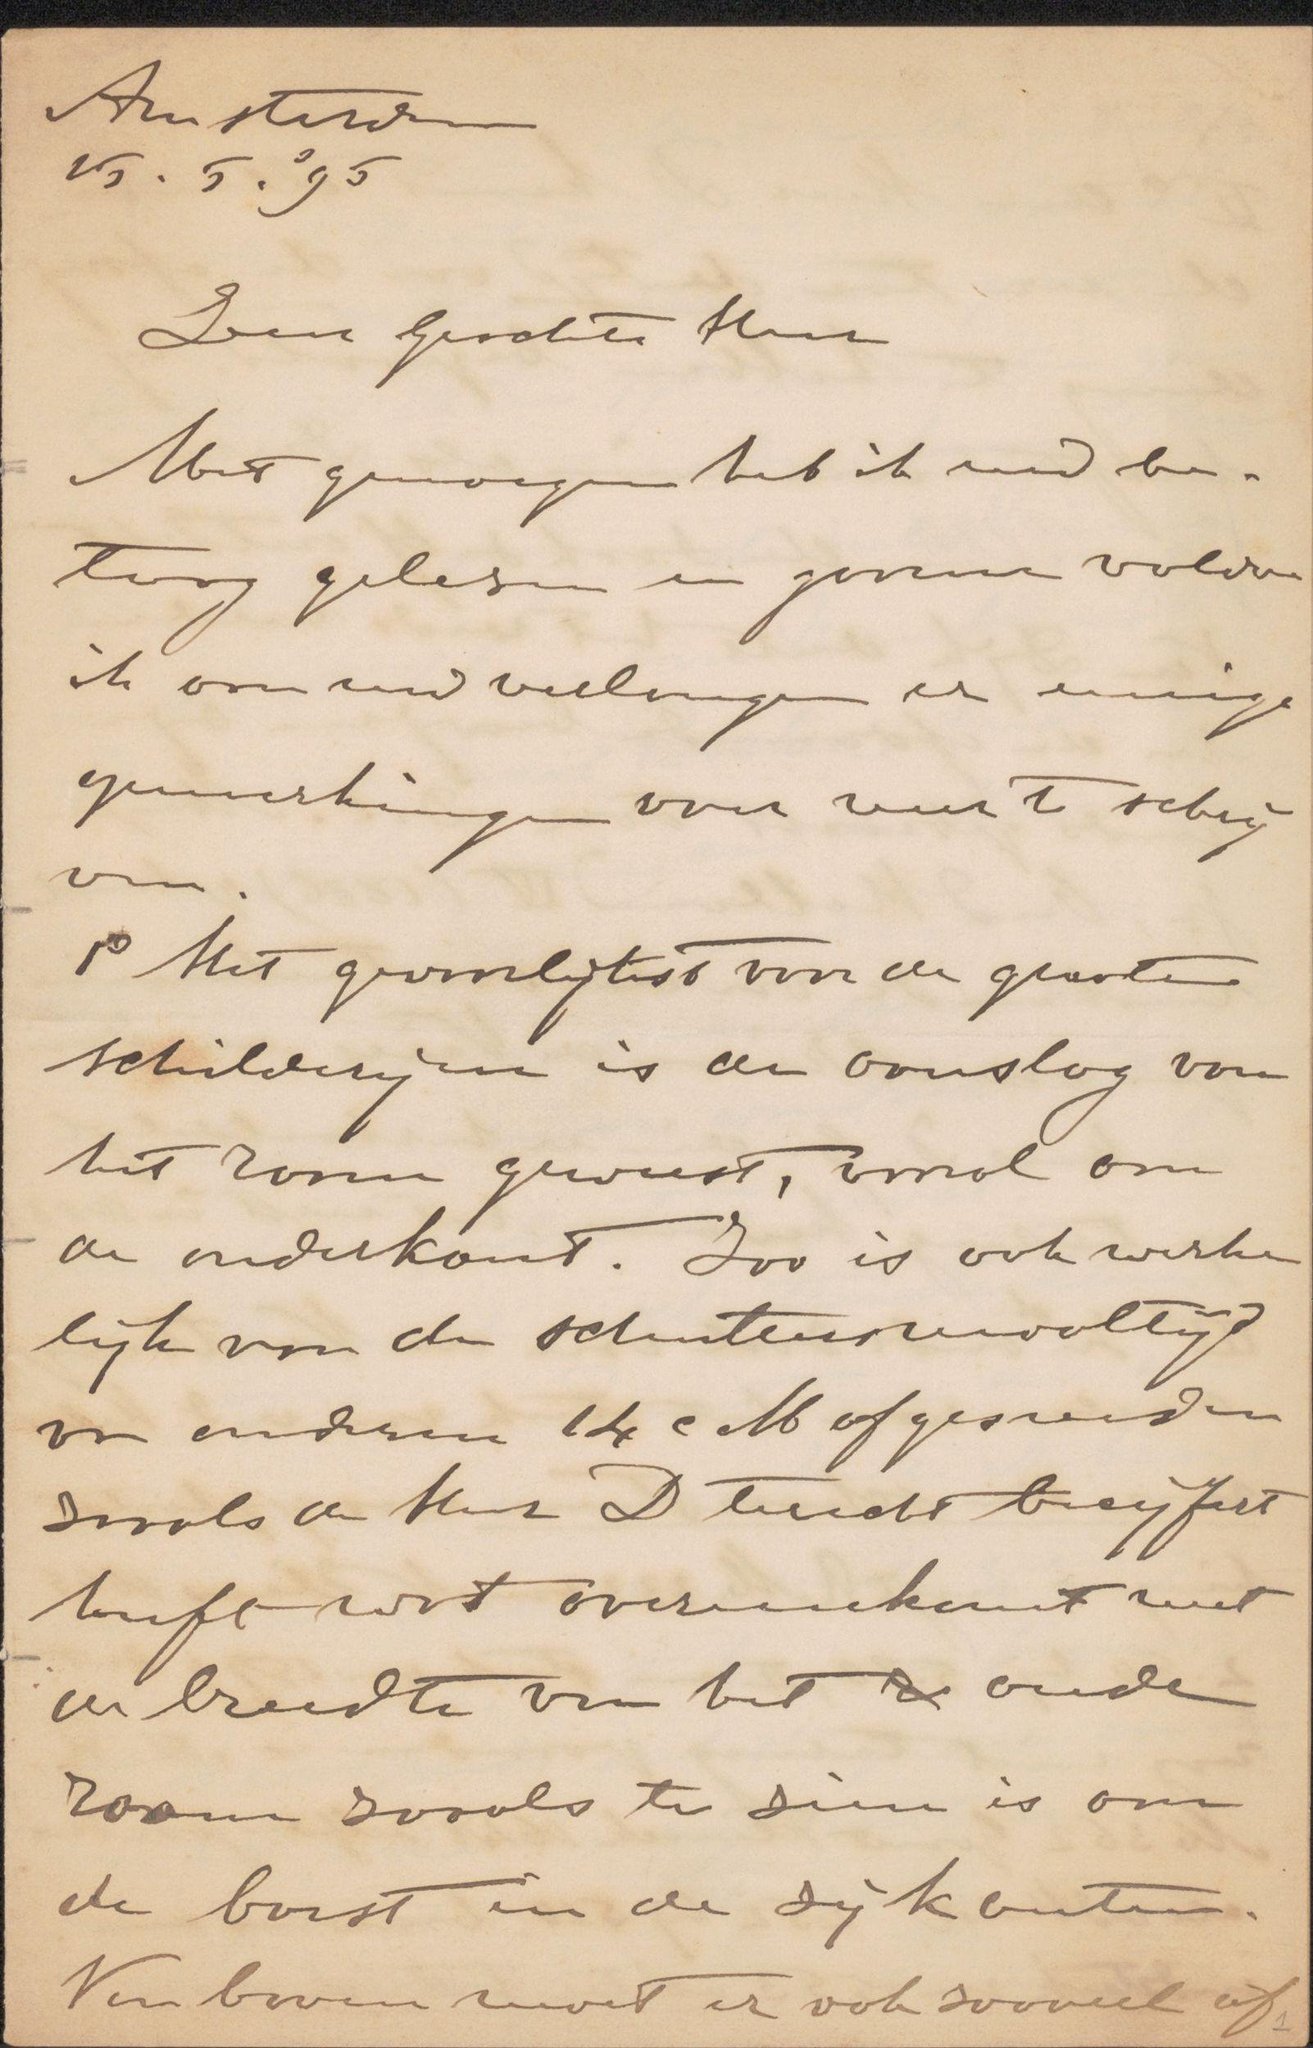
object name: letter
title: Brief aan Jan Veth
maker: jonkheer jan six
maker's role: hoogleraar, kunsthistoricus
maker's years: 1857-1926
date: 1895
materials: ink, paper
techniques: pen, writing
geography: amsterdam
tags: harlingen, jacob adriaensz backer, dordrecht, painter, print maker, draughtsman, designer, jan veth, haarlem, bartholomeus van der helst, nicolaes eliasz pickenoy, rembrandt van rijn, paris, émile durand-gréville, amsterdam, dirk christiaan meijer jr., painting (including book-illumination, miniature-painting)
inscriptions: collector's mark: ‘RPK’